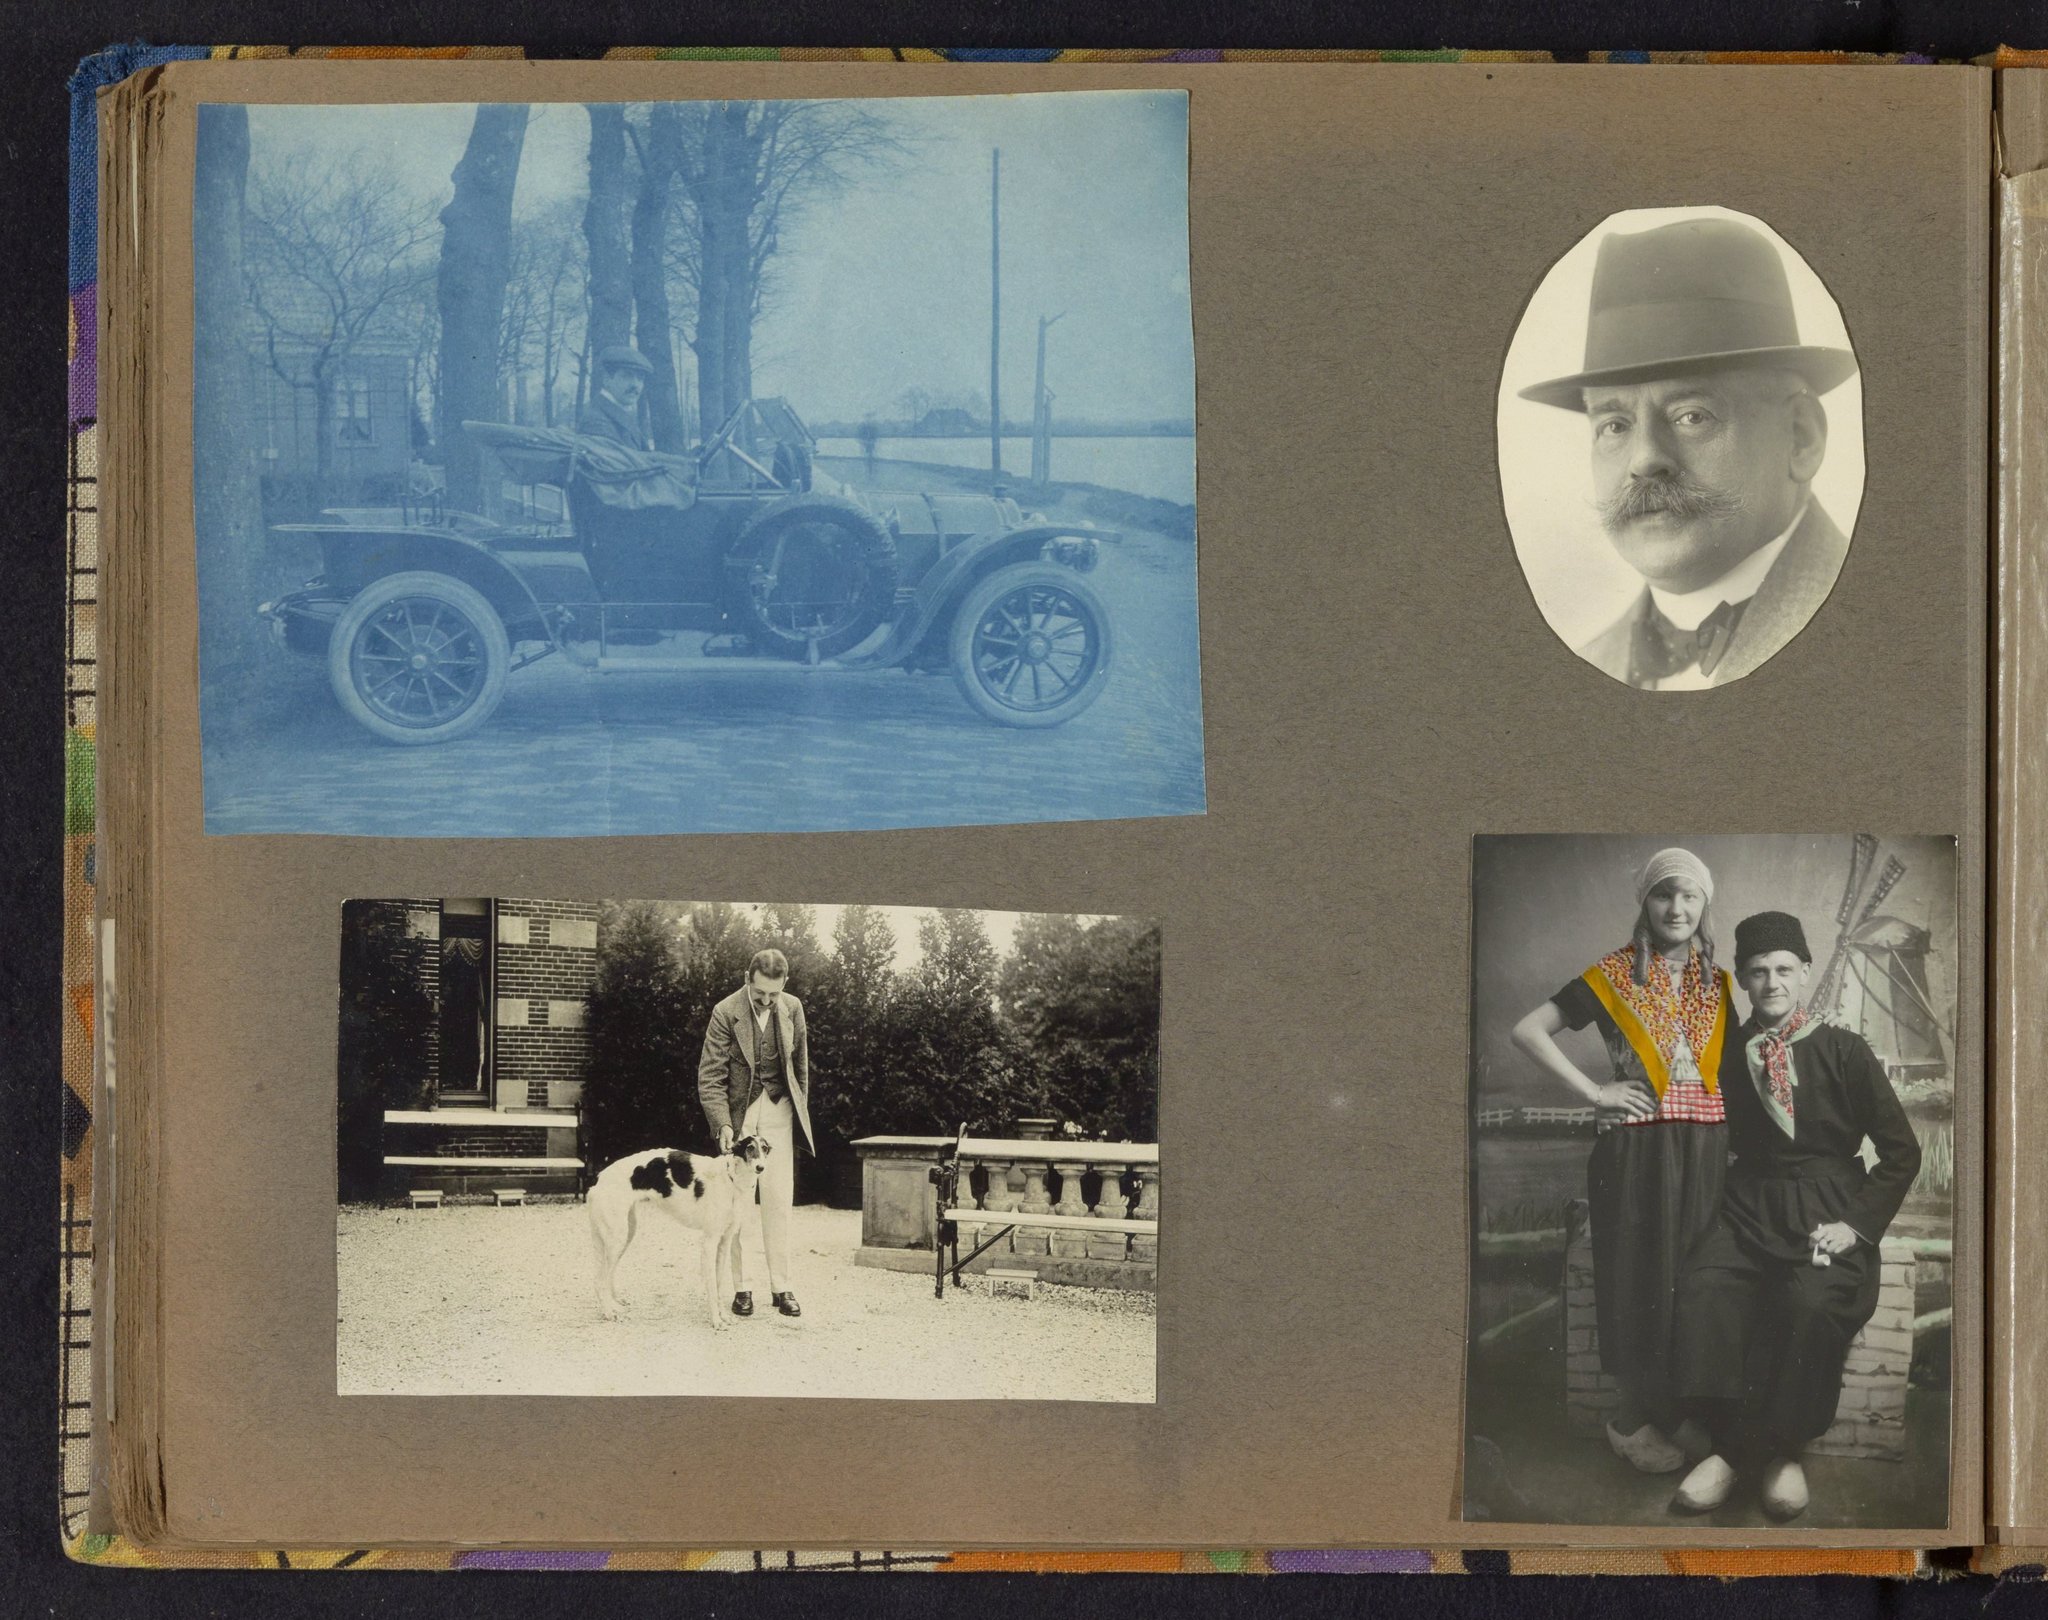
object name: album leaf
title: Portretten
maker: Anonymous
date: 1900-1925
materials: cardboard, photographic support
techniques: cyanotype, gelatin silver print, hand coloring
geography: netherlands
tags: adult man, clothes, costume (+ women's clothes), clothes, costume (+ men's clothes), automobile, dog, netherlands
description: Albumblad met foto's van een man met hoed, van een man met een hond en van een man zittend in een auto, mogelijk langs de Amstel. Ook een ingekleurde foto van een stel in traditionele visserskostuums. Onderdeel van Fotoalbum van een onbekende Nederlandse familie met connecties in Suriname en Nederlands-Indië (1).